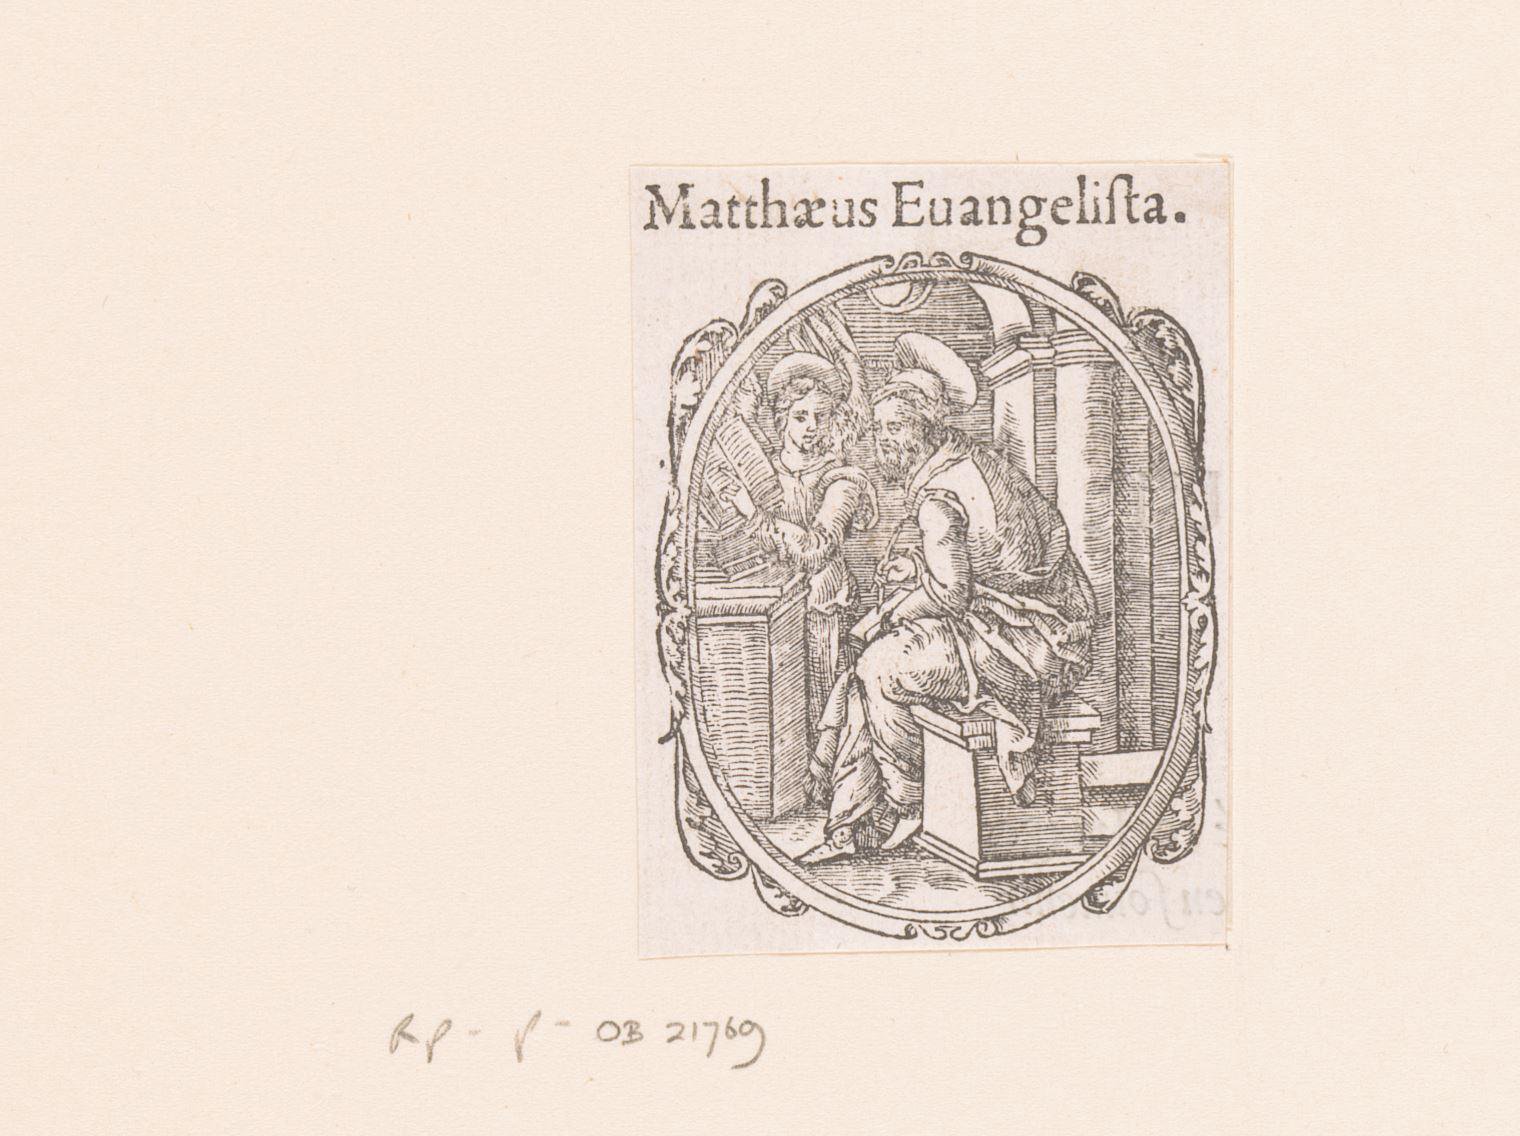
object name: book illustration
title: Evangelist Matthaeus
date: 1547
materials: paper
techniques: woodcut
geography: lyon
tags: the apostle and evangelist matthew (mattheus); possible attributes: angel, axe, book, halberd, pen and inkhorn, purse, scroll, square, sword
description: Prent afkomstig uit: Icones Historiarum Veteris Testamenti. Lyon: Johannes Frellon, 1547.